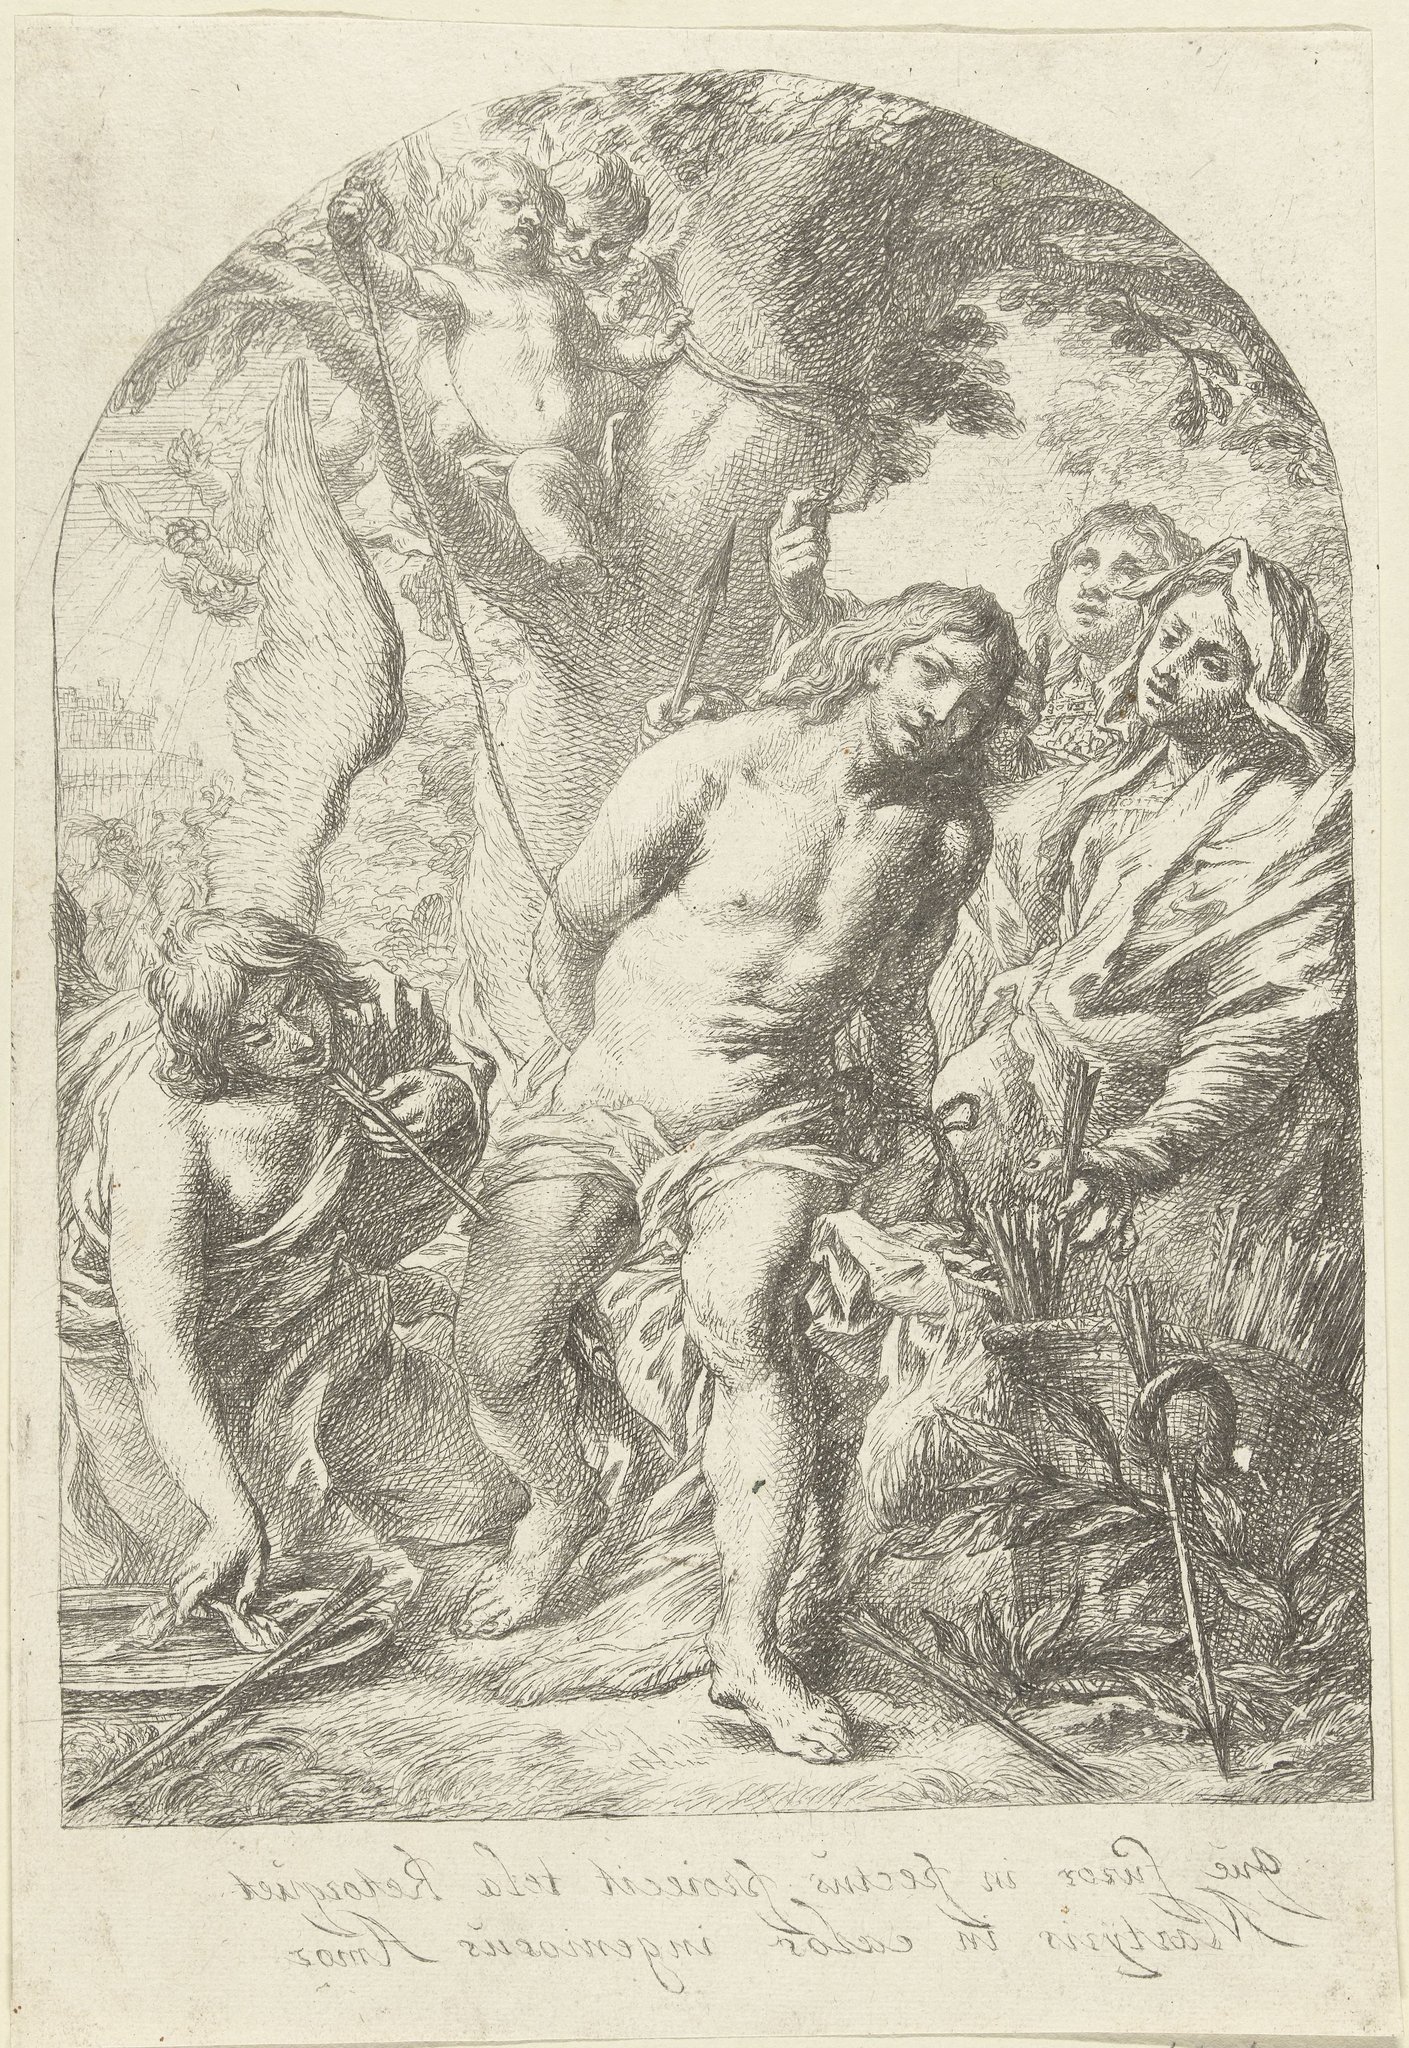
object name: print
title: H. Sebastiaan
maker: remoldus eynhoudts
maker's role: print maker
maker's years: 1613-1680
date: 1626-1680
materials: paper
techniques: printmaking, etching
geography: antwerp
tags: the martyr sebastian; possible attributes: arrow(s), bow, tree-trunk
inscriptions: collector's mark: Lugt 1838, collector's mark: Lugt 240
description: De heilige Sebastiaan is met zijn armen vastgebonden aan een boom. Een pijl doorboort zijn been. Naast hem twee personen en een mand met pijlen, aan de andere kant een engel die zijn wonden verzorgt. Onder de voorstelling twee regels Latijn.